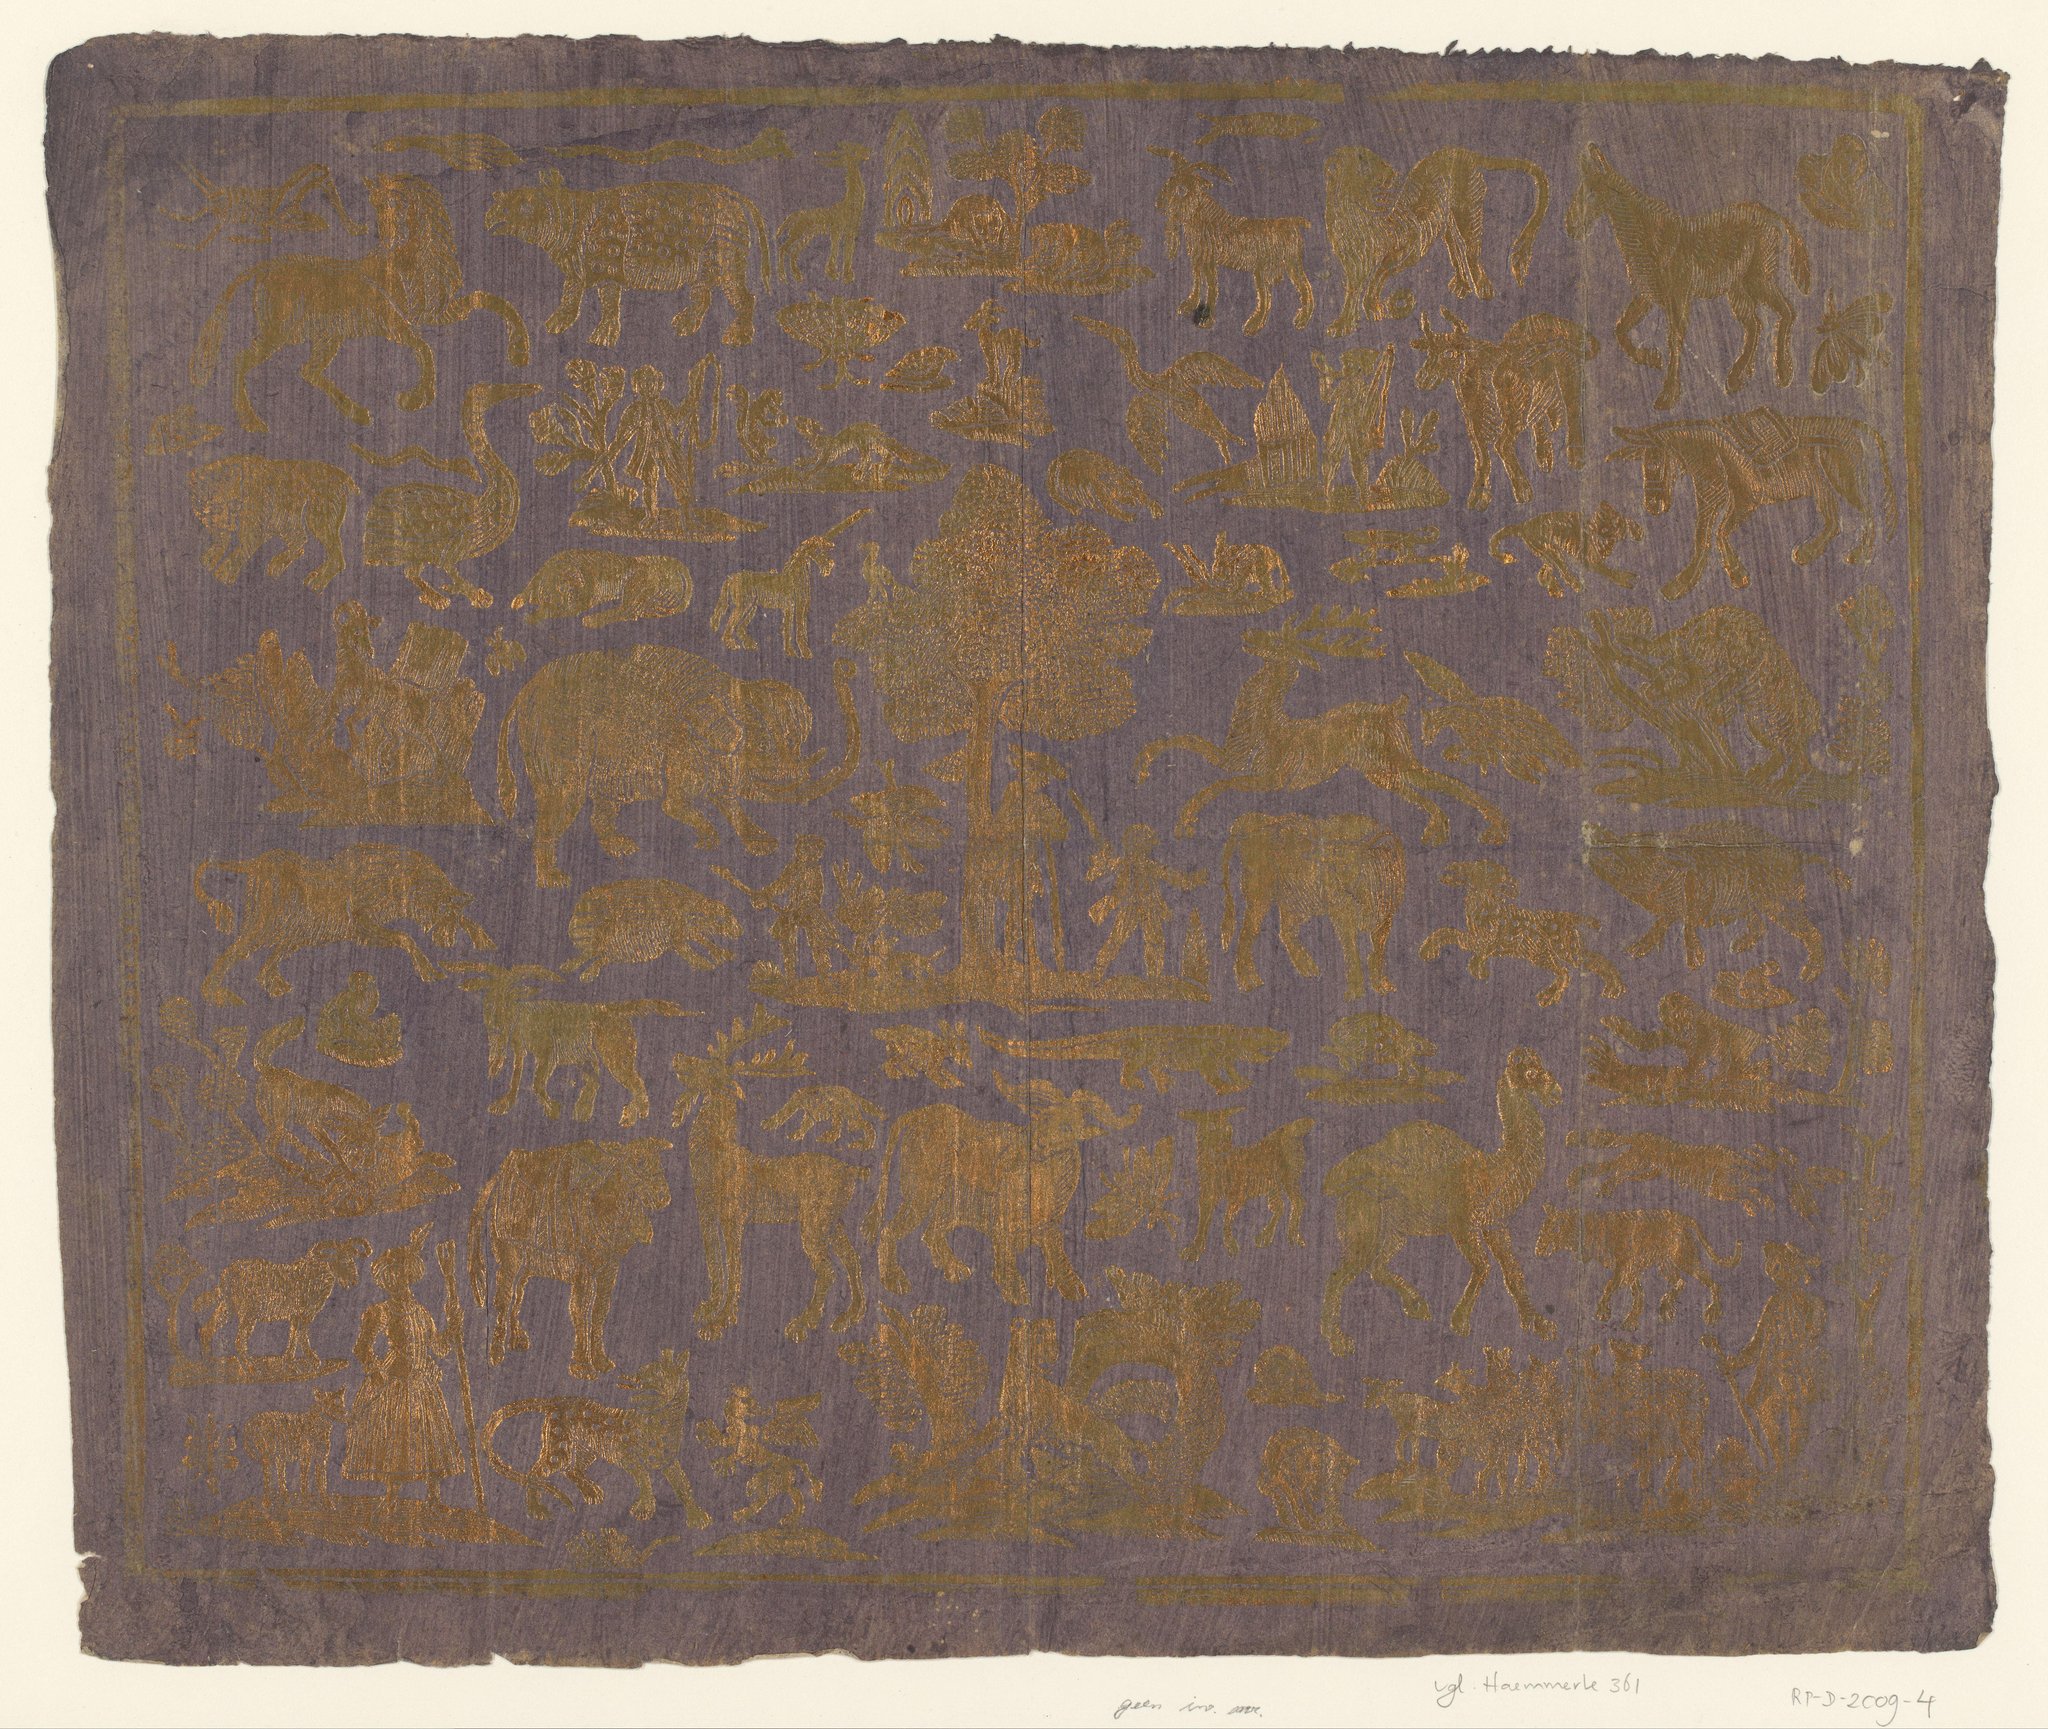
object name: brocade paper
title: Blad met dieren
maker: Anonymous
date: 1800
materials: gold leaf, paint, paper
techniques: relief print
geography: nuremberg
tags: animals, cattle, hunter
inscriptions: collector's mark: Lugt 2228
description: Hetzelfde patroon als Haemmerle nr. 361, maar met minder insecten tussen de dieren en zonder het adres van Paul Reimund en zonder nummer.